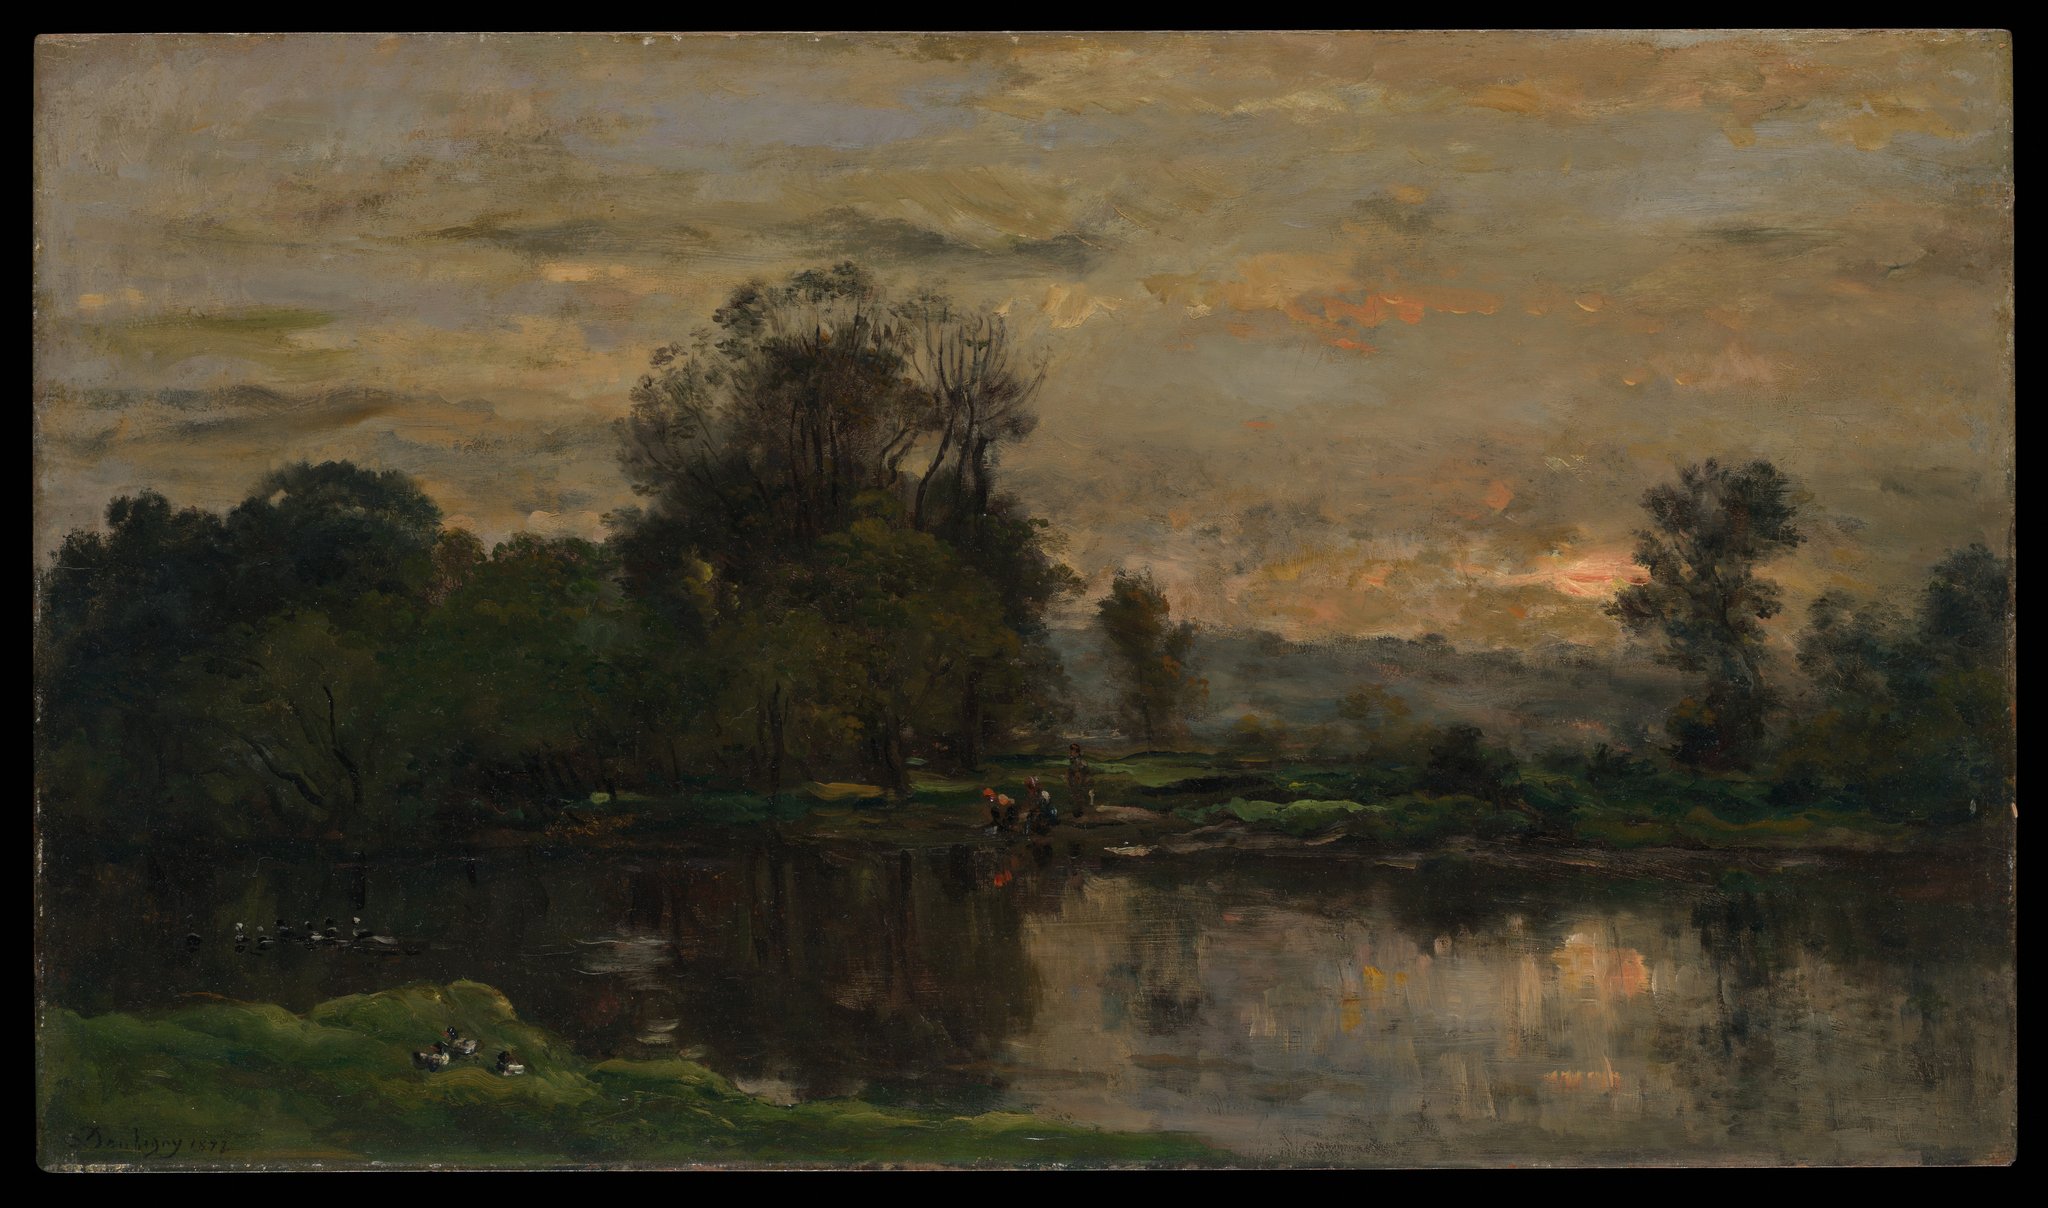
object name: painting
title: Landscape with Ducks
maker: charles-françois daubigny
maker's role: artist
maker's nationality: french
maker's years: 1817-1878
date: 1872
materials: oil, wood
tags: ducks,landscapes